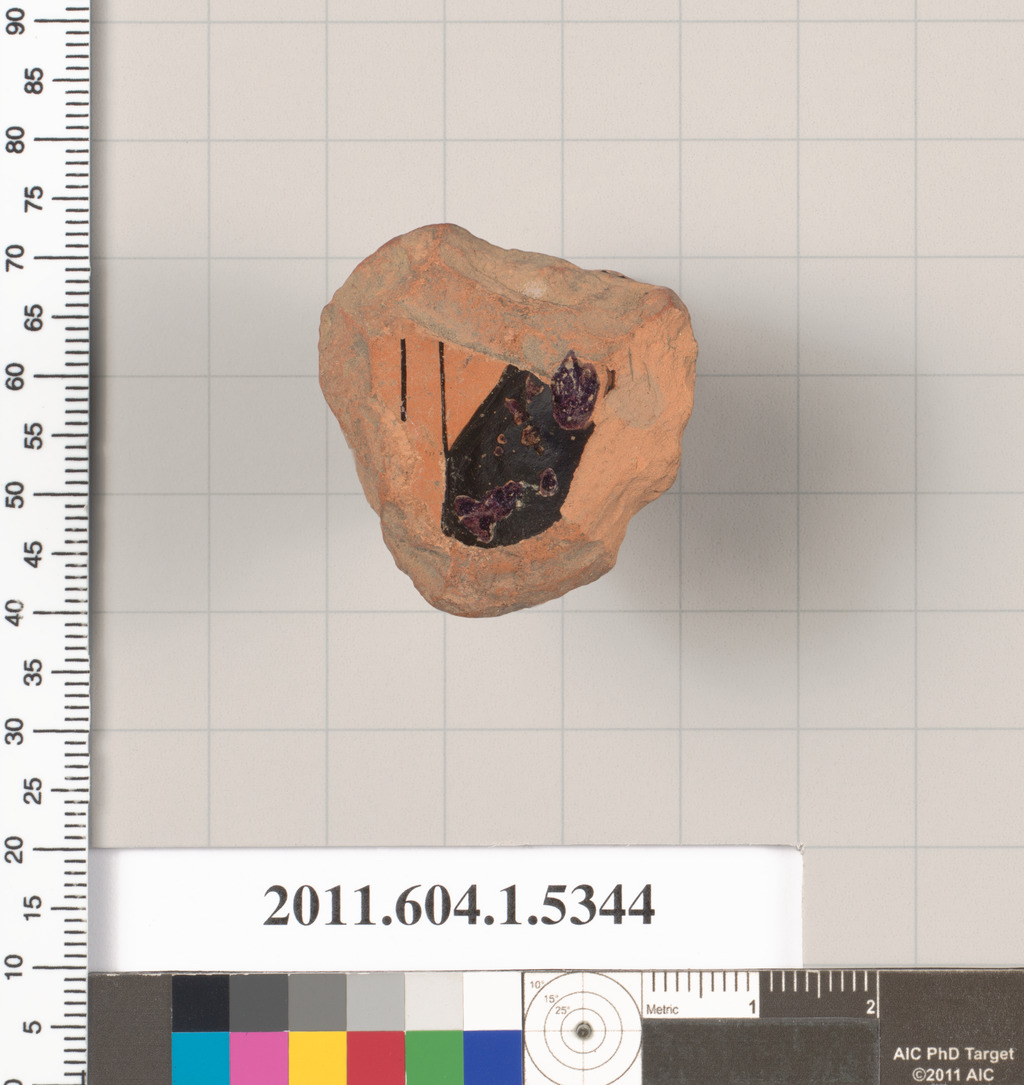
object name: kylix fragment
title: Terracotta fragment of a kylix (drinking cup)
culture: greek, attic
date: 500-480 BCE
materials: terracotta